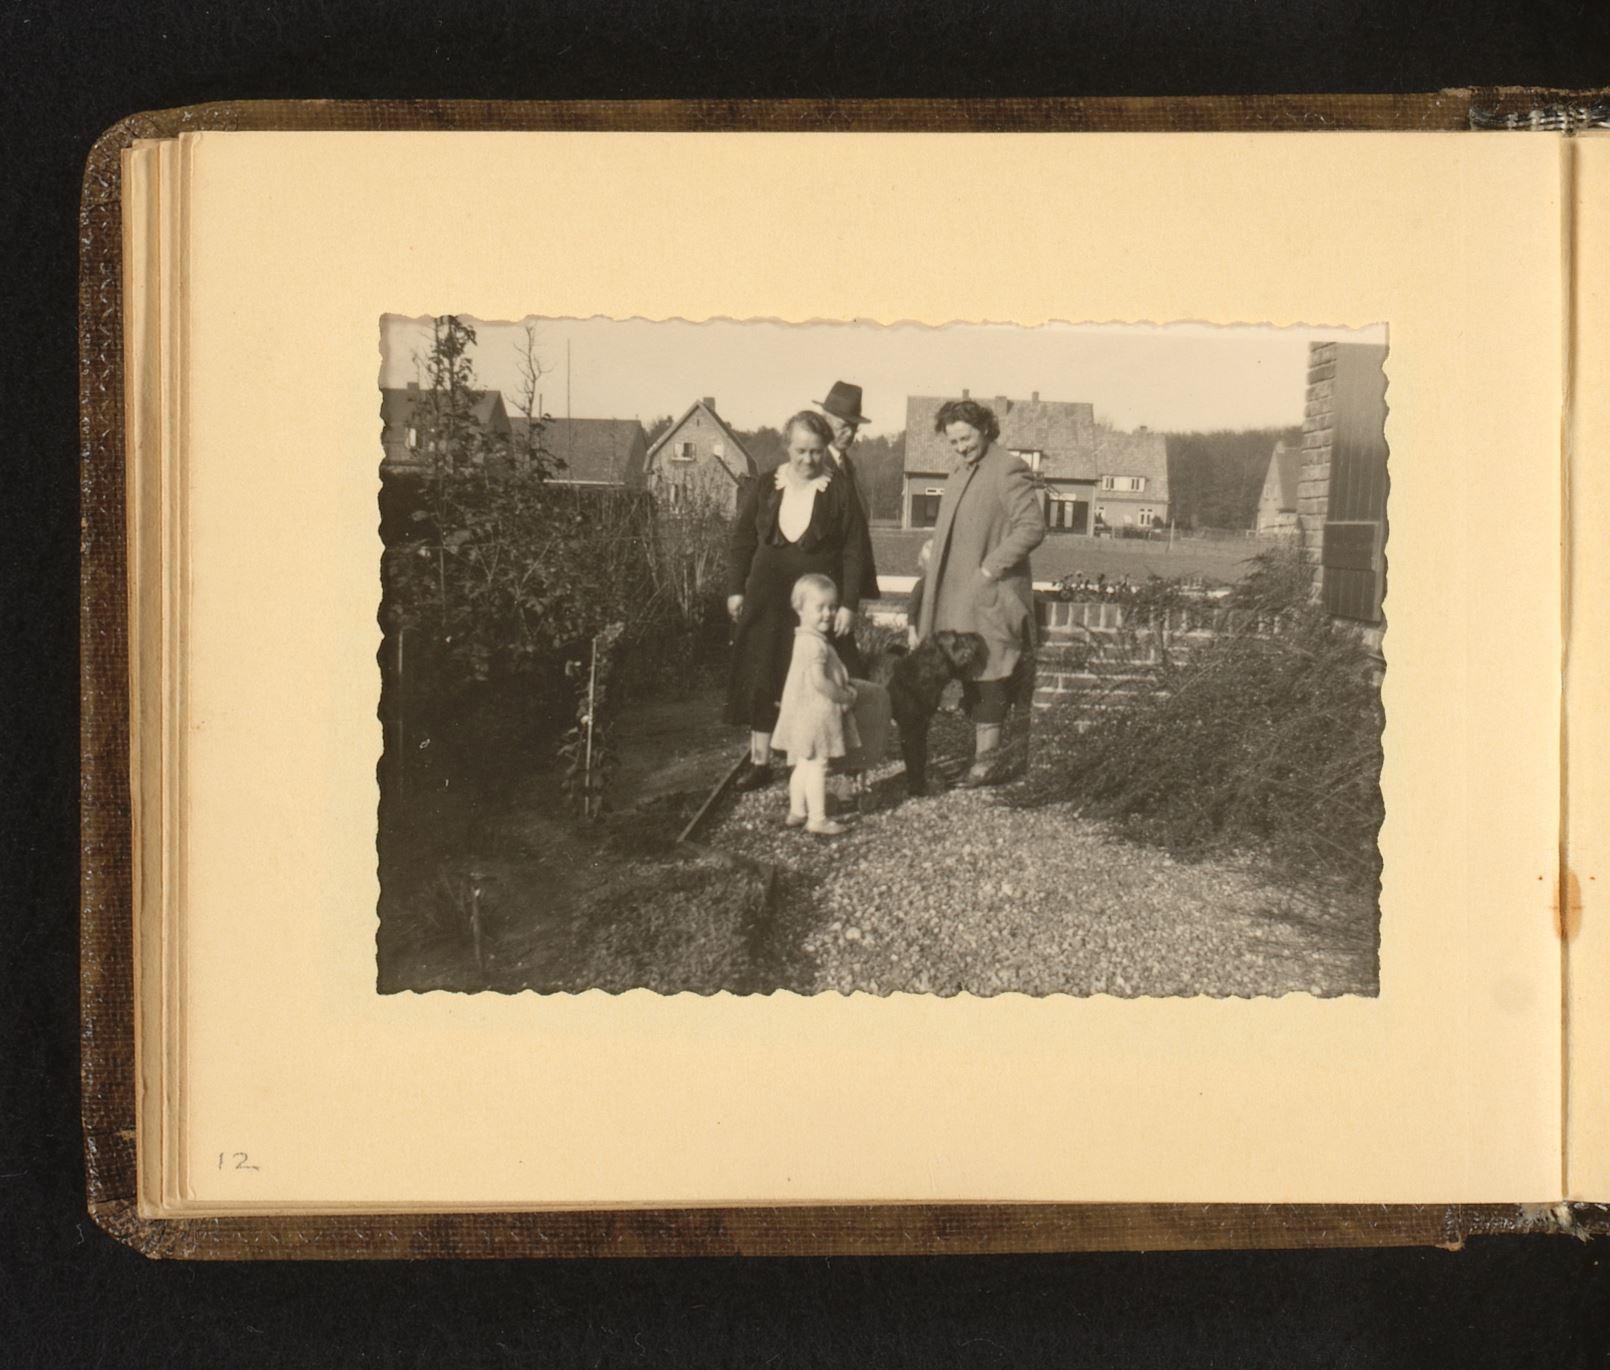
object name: album leaf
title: Kind en volwassenen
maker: Anonymous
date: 1911-1938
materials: cardboard, photographic support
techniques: gelatin silver print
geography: eefde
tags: family life at home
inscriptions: inscription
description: Albumblad met een foto van een kind met hond en drie volwassenen. Onderdeel van het familiealbum 1938-1939.